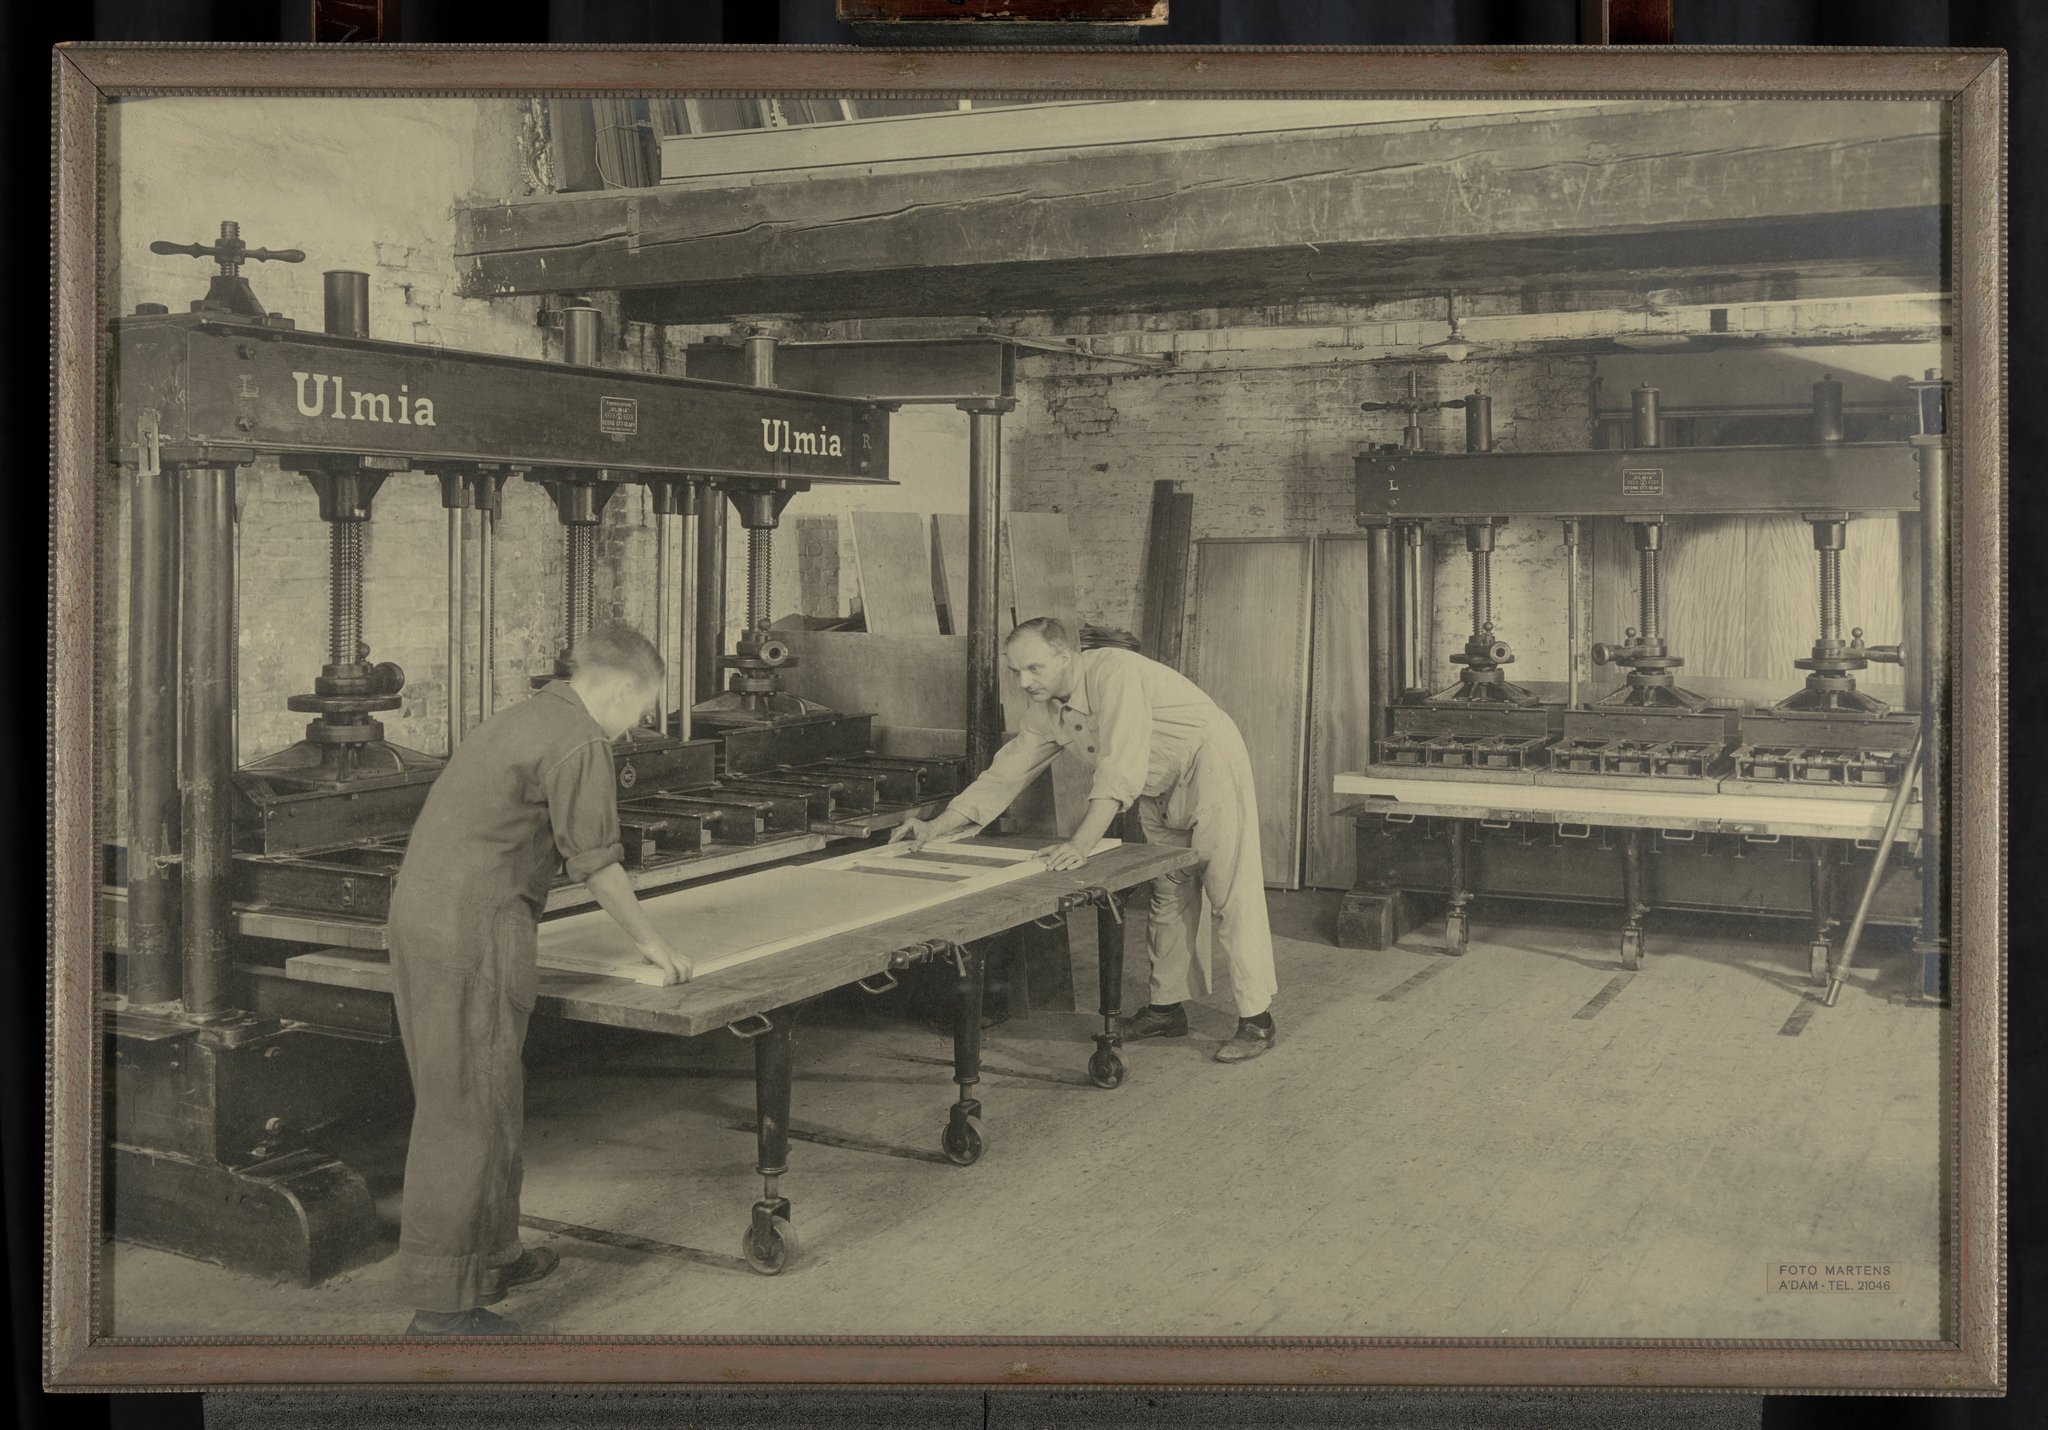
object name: photograph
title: werkplaats van 't Woonhuys, Amsterdam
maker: martens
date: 1925-1940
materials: cardboard, glass, photographic support, wood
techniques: gelatin silver print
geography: amsterdam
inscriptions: label: ‘FOTO MARTENS / A'DAM - TEL. 21046’